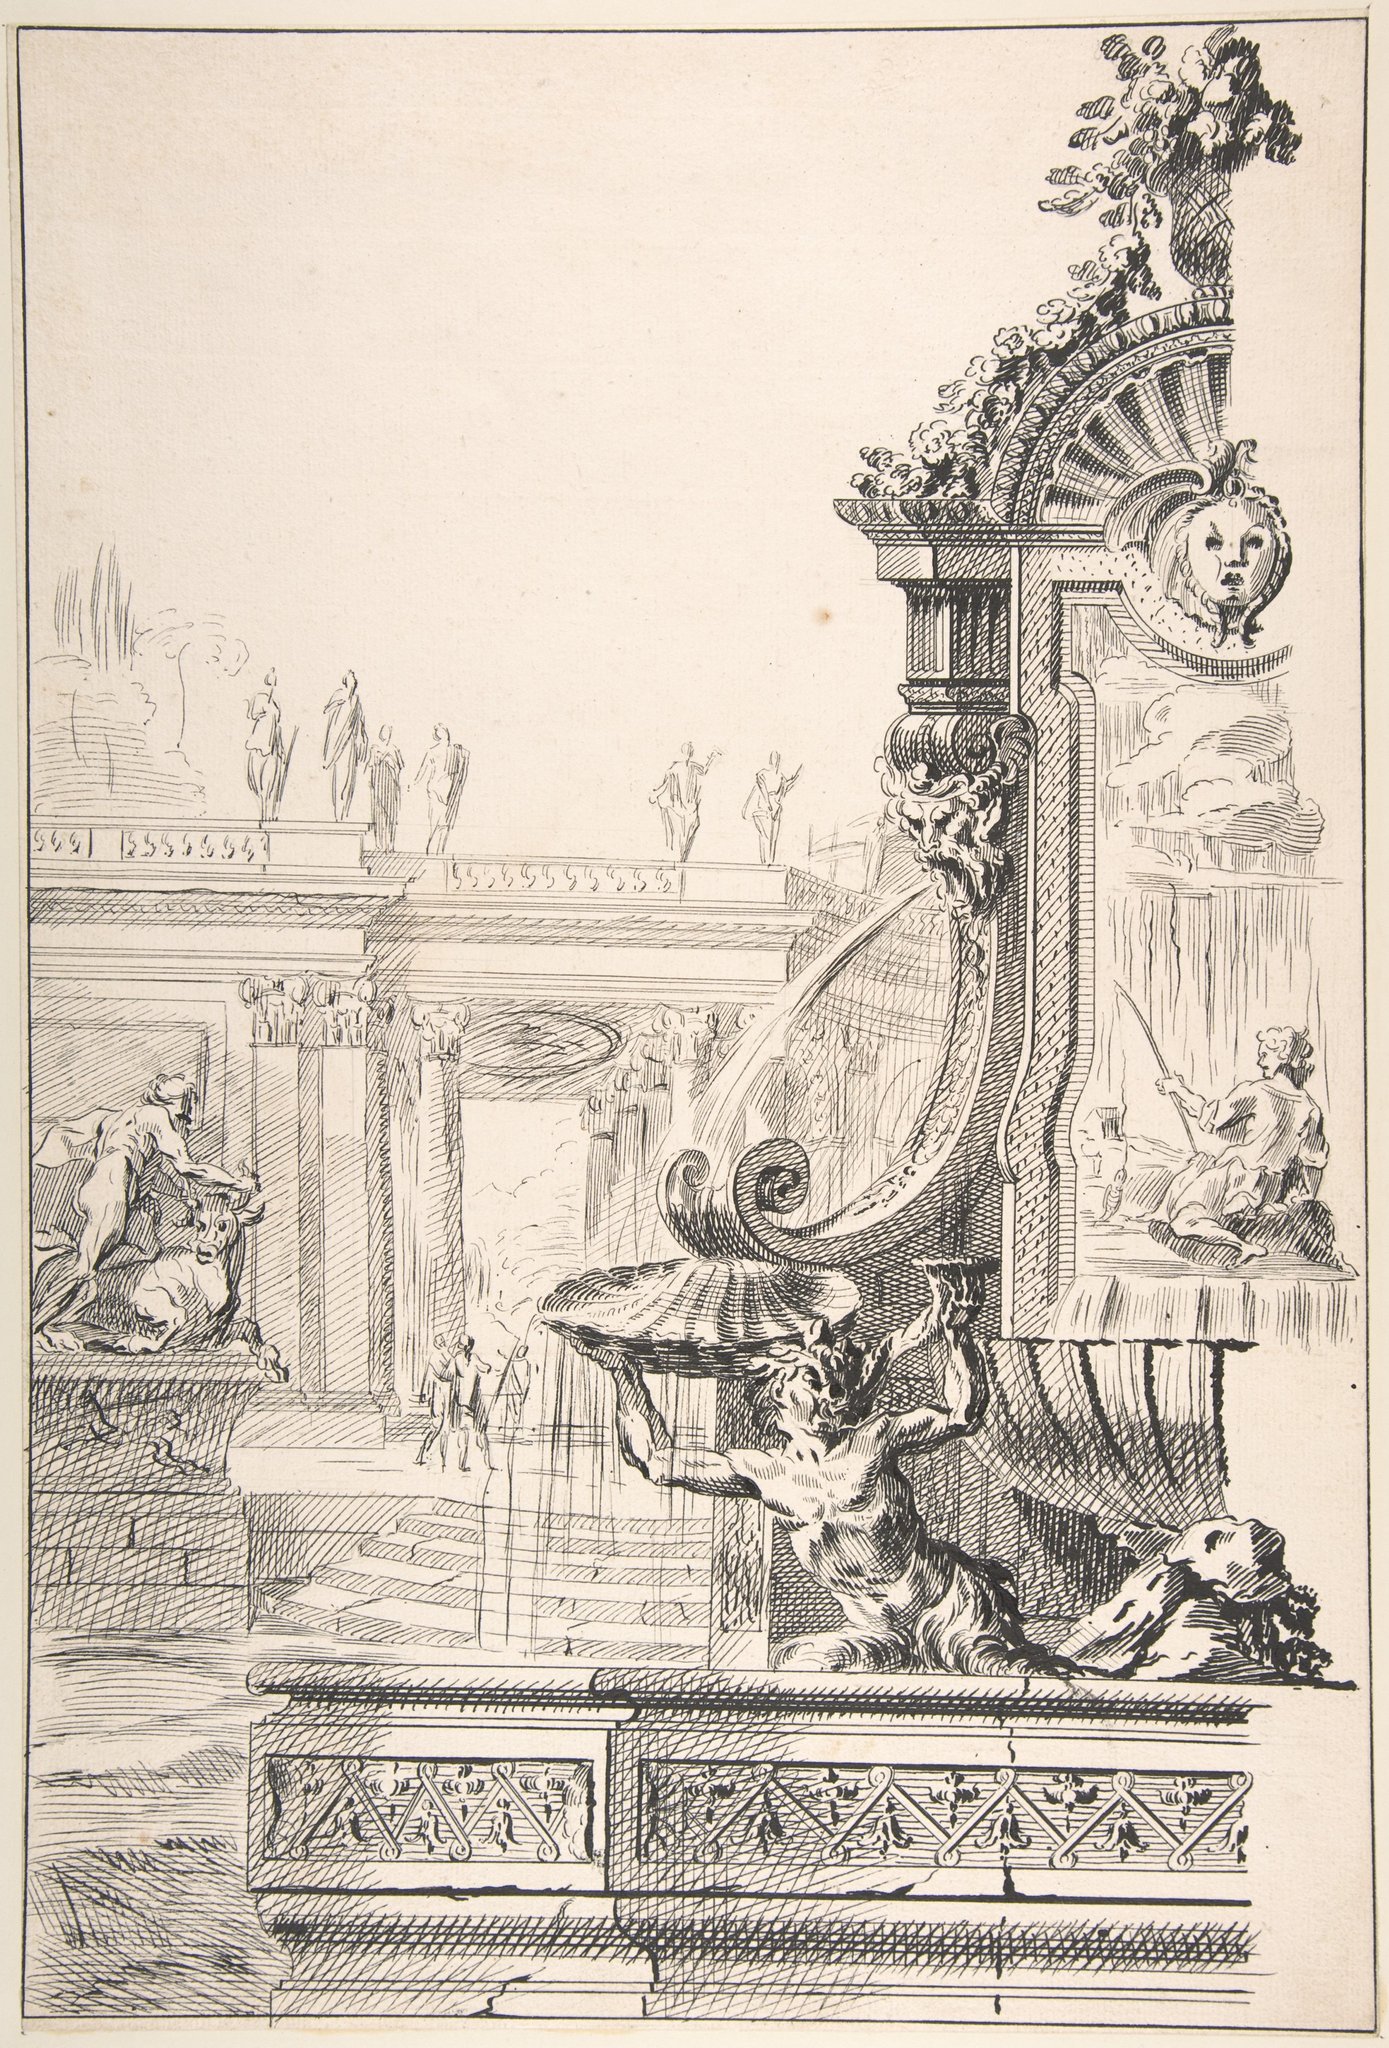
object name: drawing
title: Design for a Garden Capriccio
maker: gilles-marie oppenord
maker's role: artist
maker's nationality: french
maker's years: 1672-1742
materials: graphite, ink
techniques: pen, drawing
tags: architecture,fountains